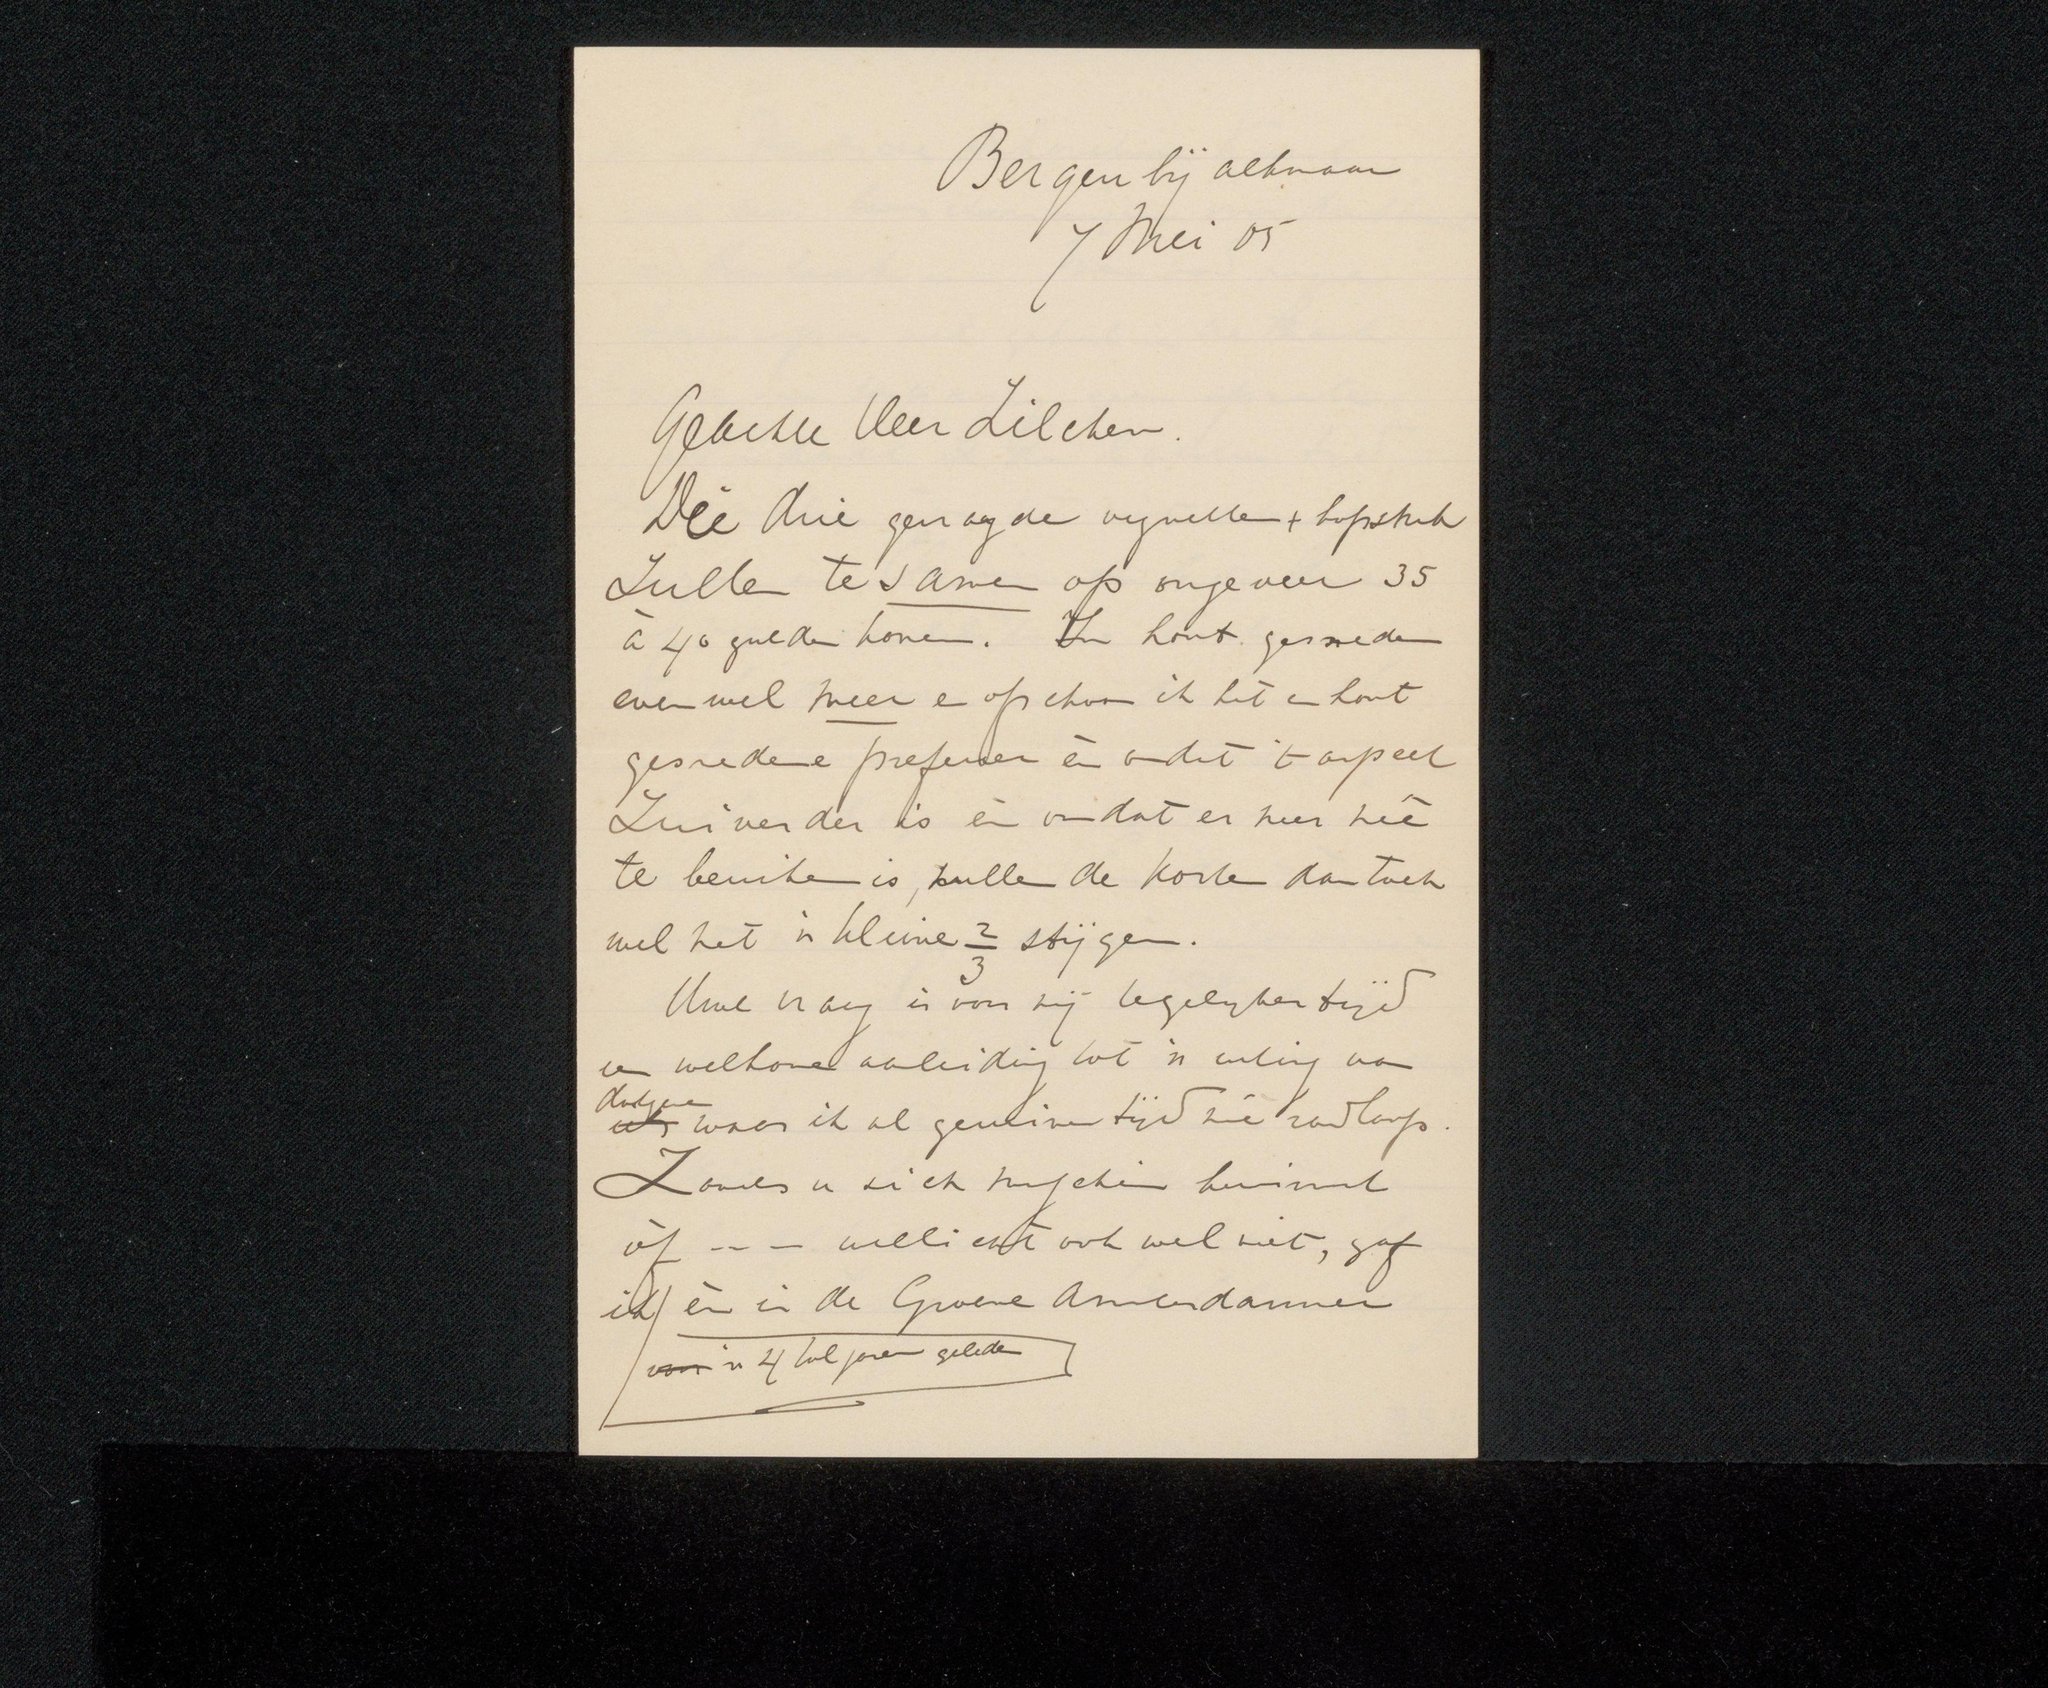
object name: letter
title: Brief aan Philip Zilcken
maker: jacobus gerardus veldheer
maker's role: draughtsman, print maker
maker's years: 1866-1954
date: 1905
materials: ink, paper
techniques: pen, writing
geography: bergen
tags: the hague, philip zilcken, applied arts, arts and crafts; industrial design, money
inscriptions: collector's mark: ‘RPK’